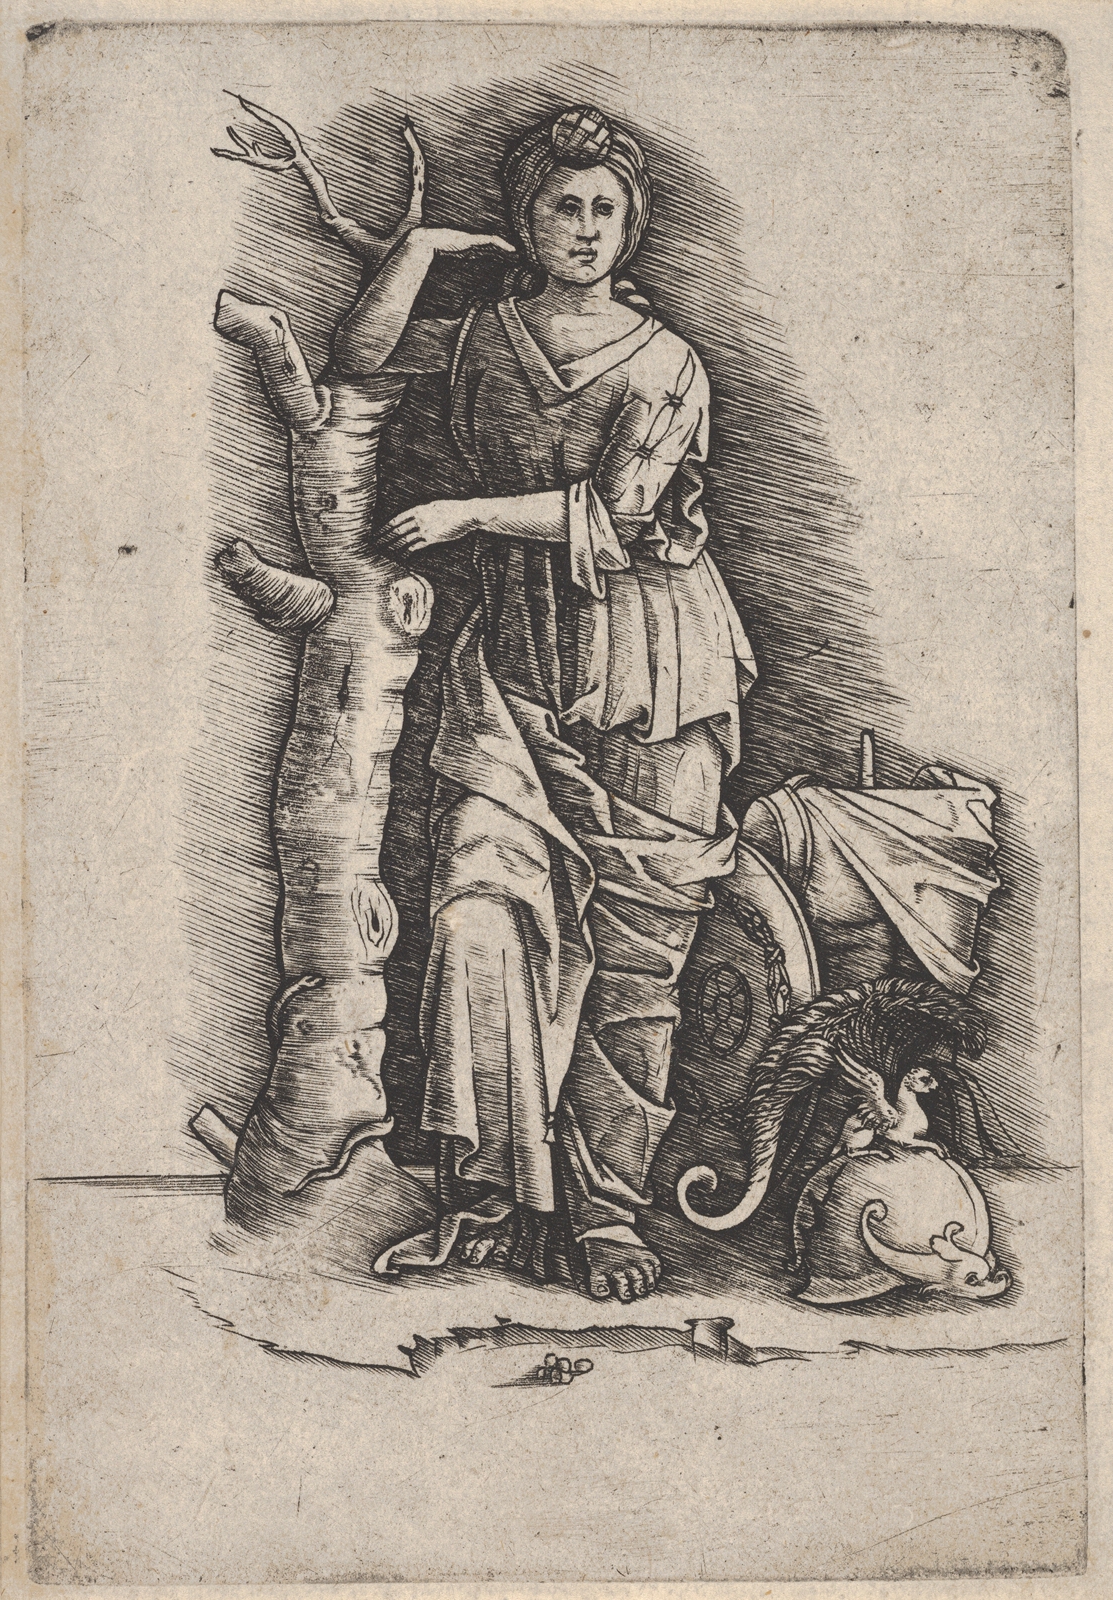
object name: print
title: Victory or Minerva, helmet on the groud to the right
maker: nicoletto da modena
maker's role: artist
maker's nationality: italian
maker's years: 1500-1520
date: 1500-1510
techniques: engraving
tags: minerva